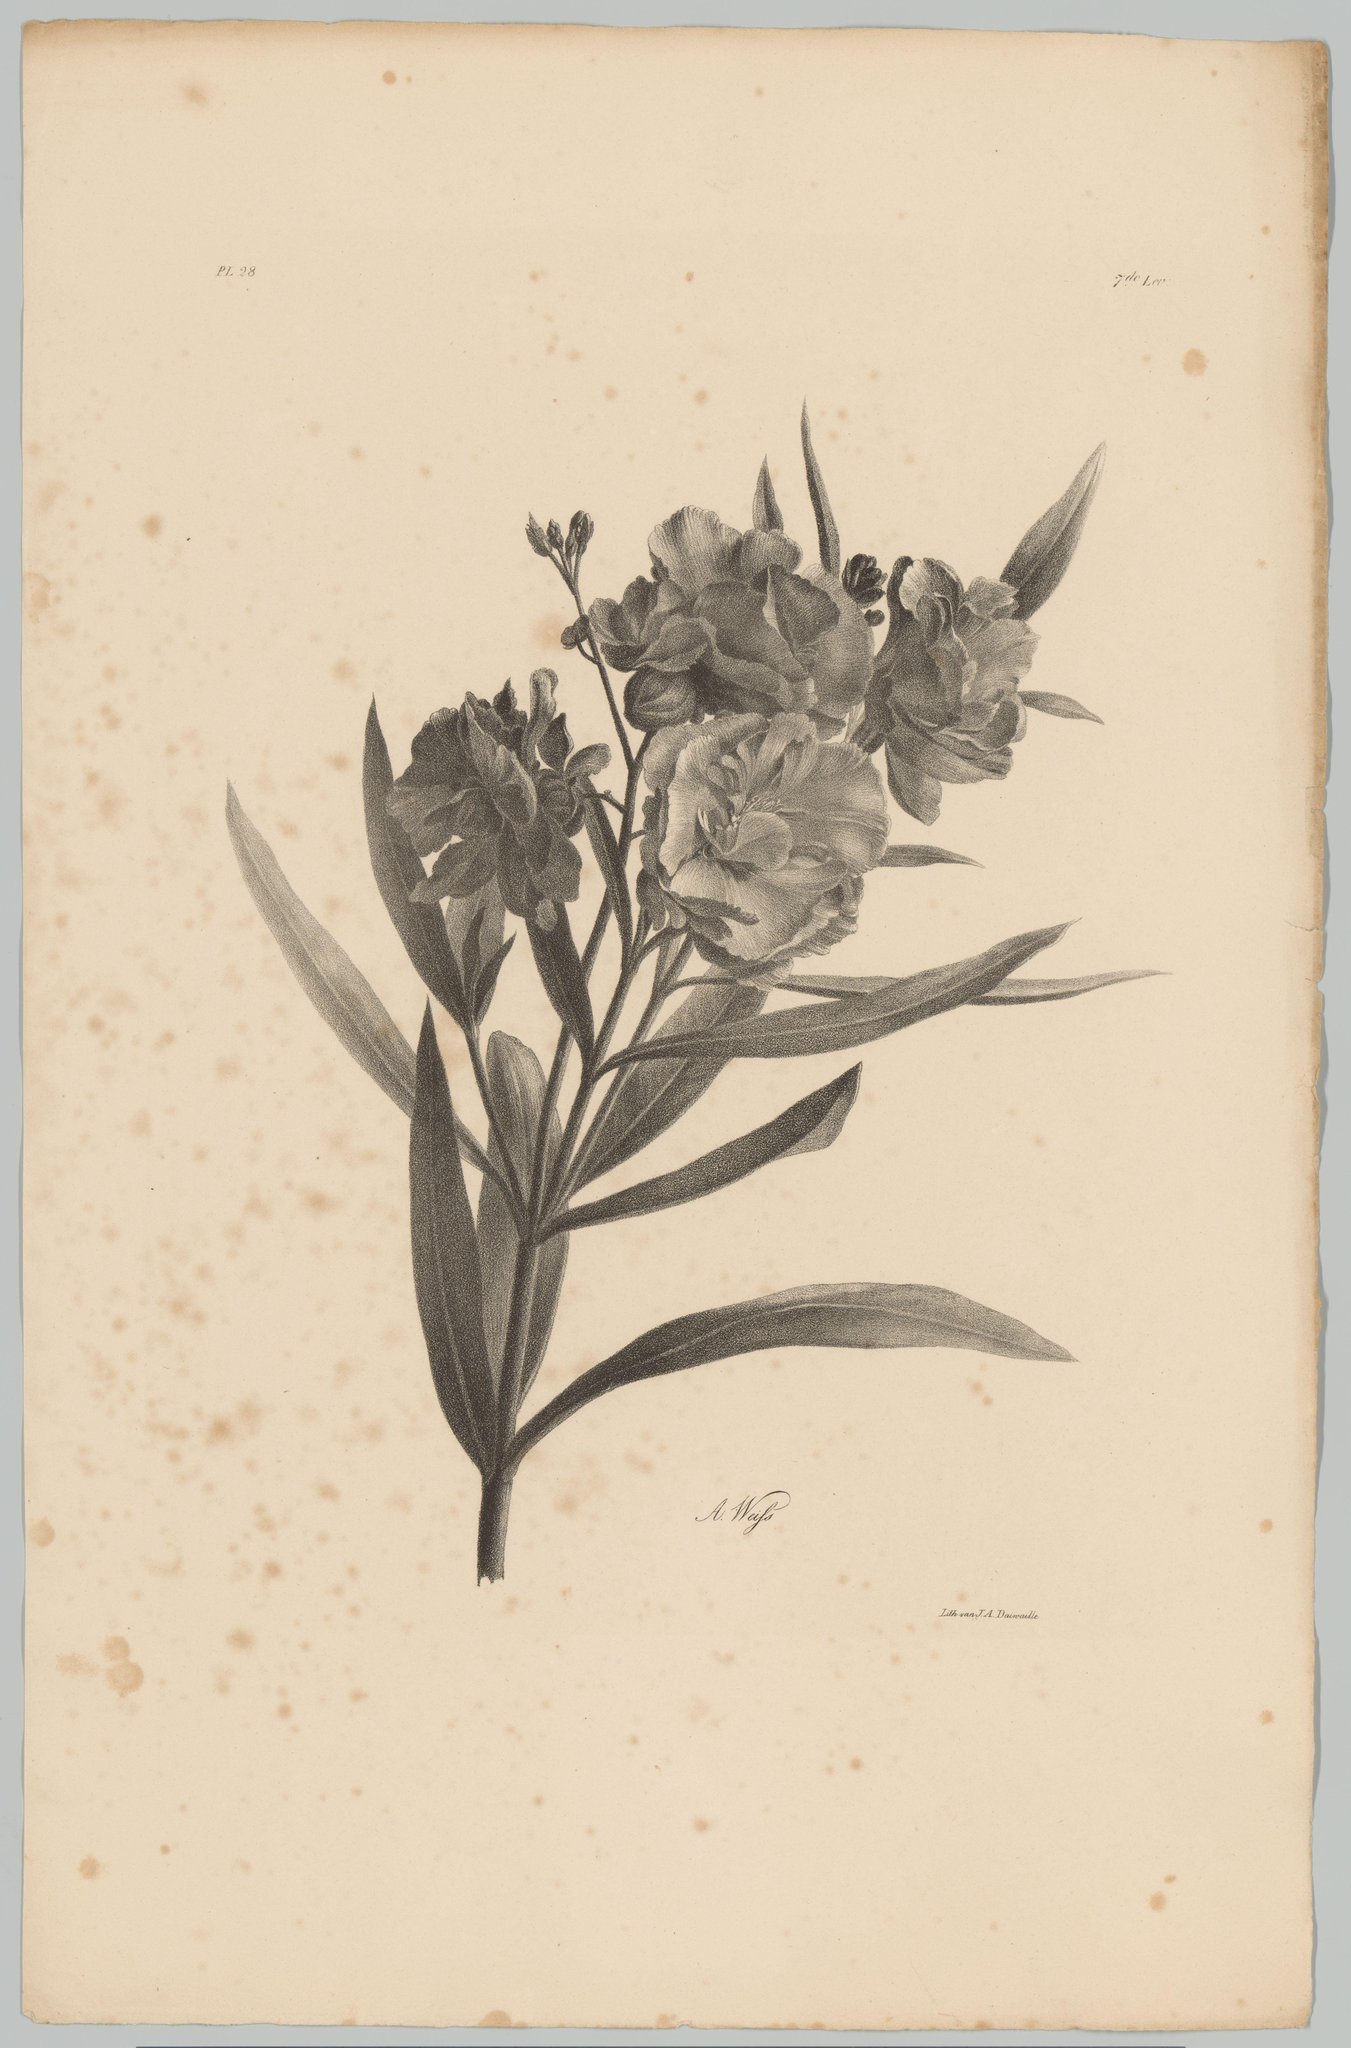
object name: print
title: Bloem en Fruit Studien (...) 3de aflevering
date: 1820-1833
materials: paper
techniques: lithograph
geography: amsterdam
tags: flowers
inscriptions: collector's mark: Lugt 2228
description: Rechts boven genummerd 7de Lev. Onderdeel van een omslag met in totaal zevenenzeventig lithografieën van bloemen en fruit.